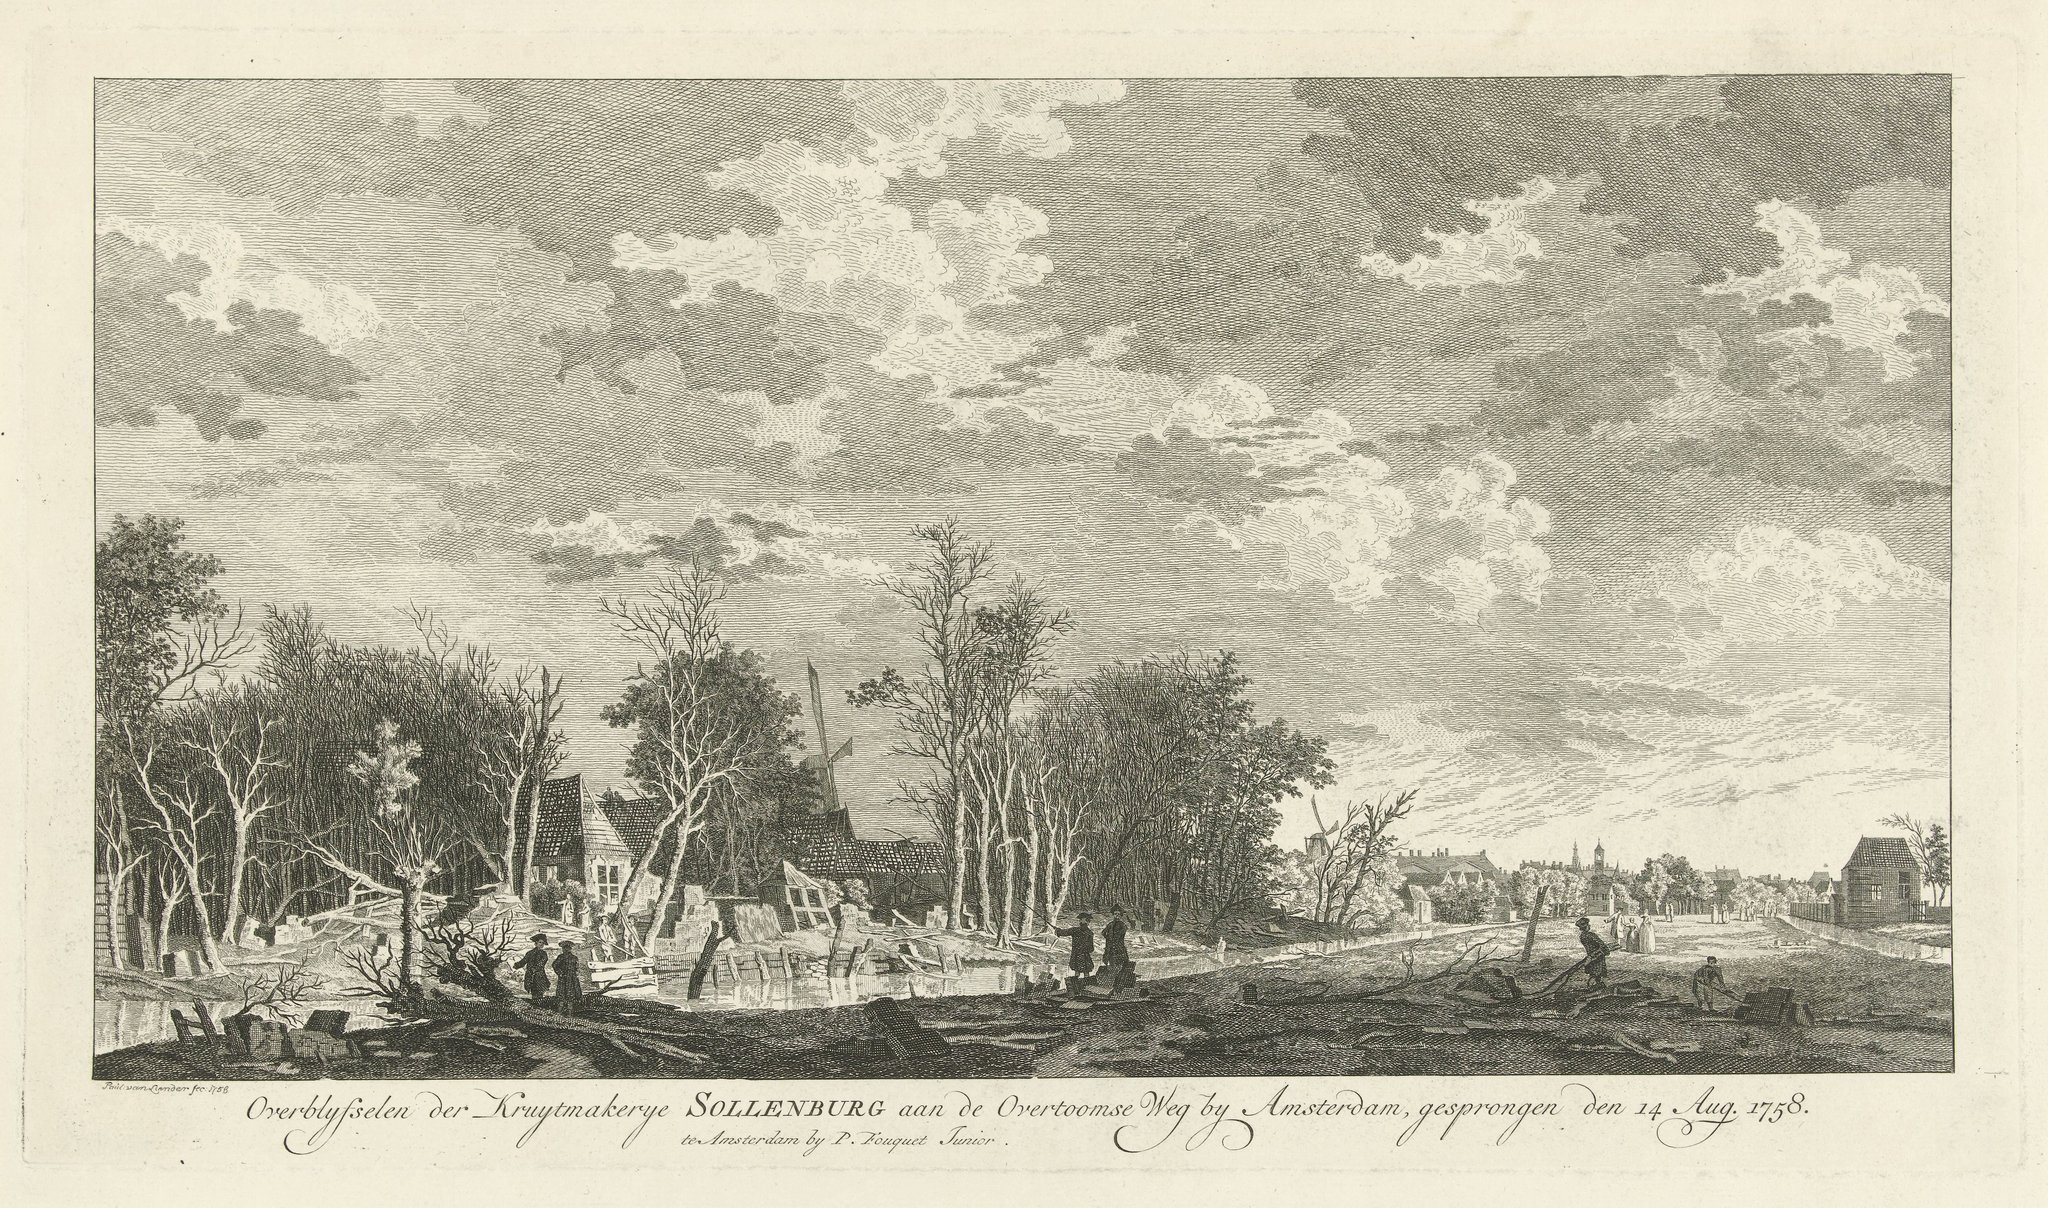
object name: print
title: Ruïne van de kruitfabriek Sollenburg na de ontploffing op 14 augustus 1758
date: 1758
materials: paper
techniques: engraving, etching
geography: amsterdam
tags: gunpowder disaster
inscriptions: collector's mark: Lugt 2228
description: Gezicht op de ruïne van de kruitfabriek in de kruitmolen Sollenburg aan de Overtoom te Amsterdam na de ontploffing op 14 augustus 1758.